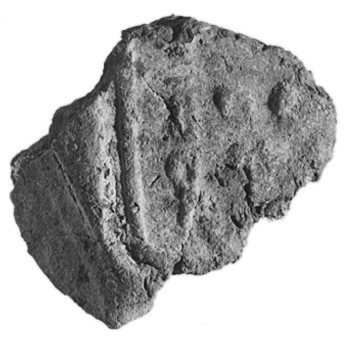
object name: sealing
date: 2030-1640 BCE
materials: clay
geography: egypt